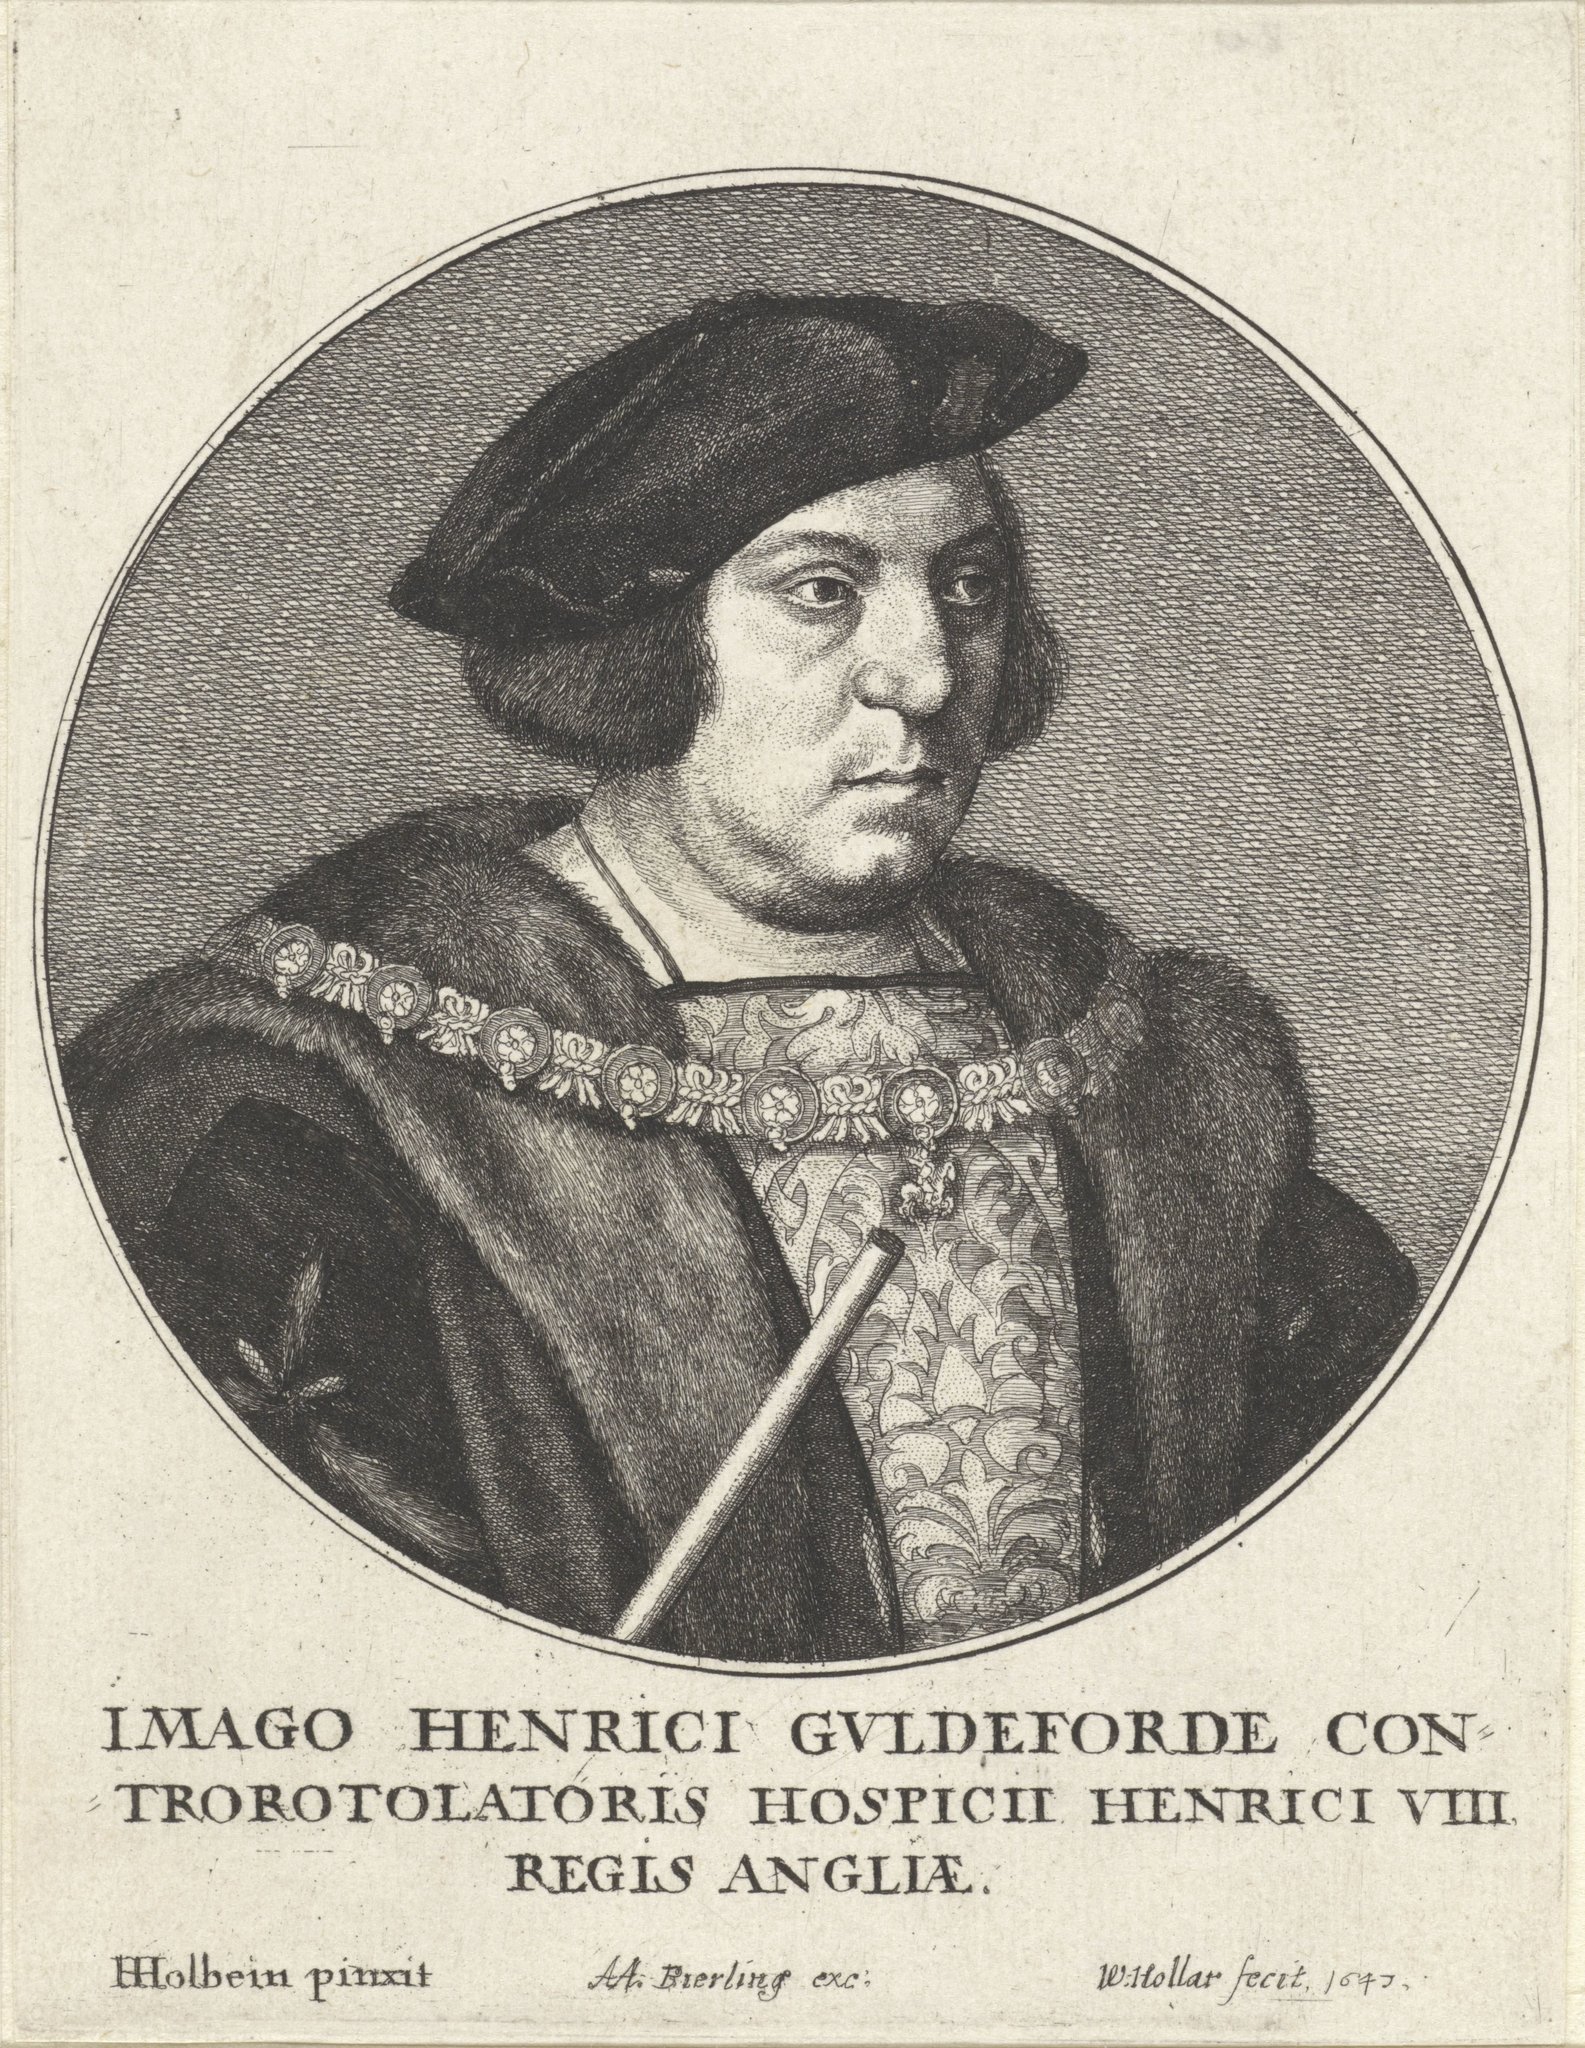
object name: print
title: Portret van Sir Henry Guildford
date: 1647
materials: paper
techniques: etching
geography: antwerp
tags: hofdignitaris, henry guildford (sir)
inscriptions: collector's mark: Lugt 240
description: Portret van Sir Henry Guildford, hofdignitaris van koning Hendrik VIII van Engeland.